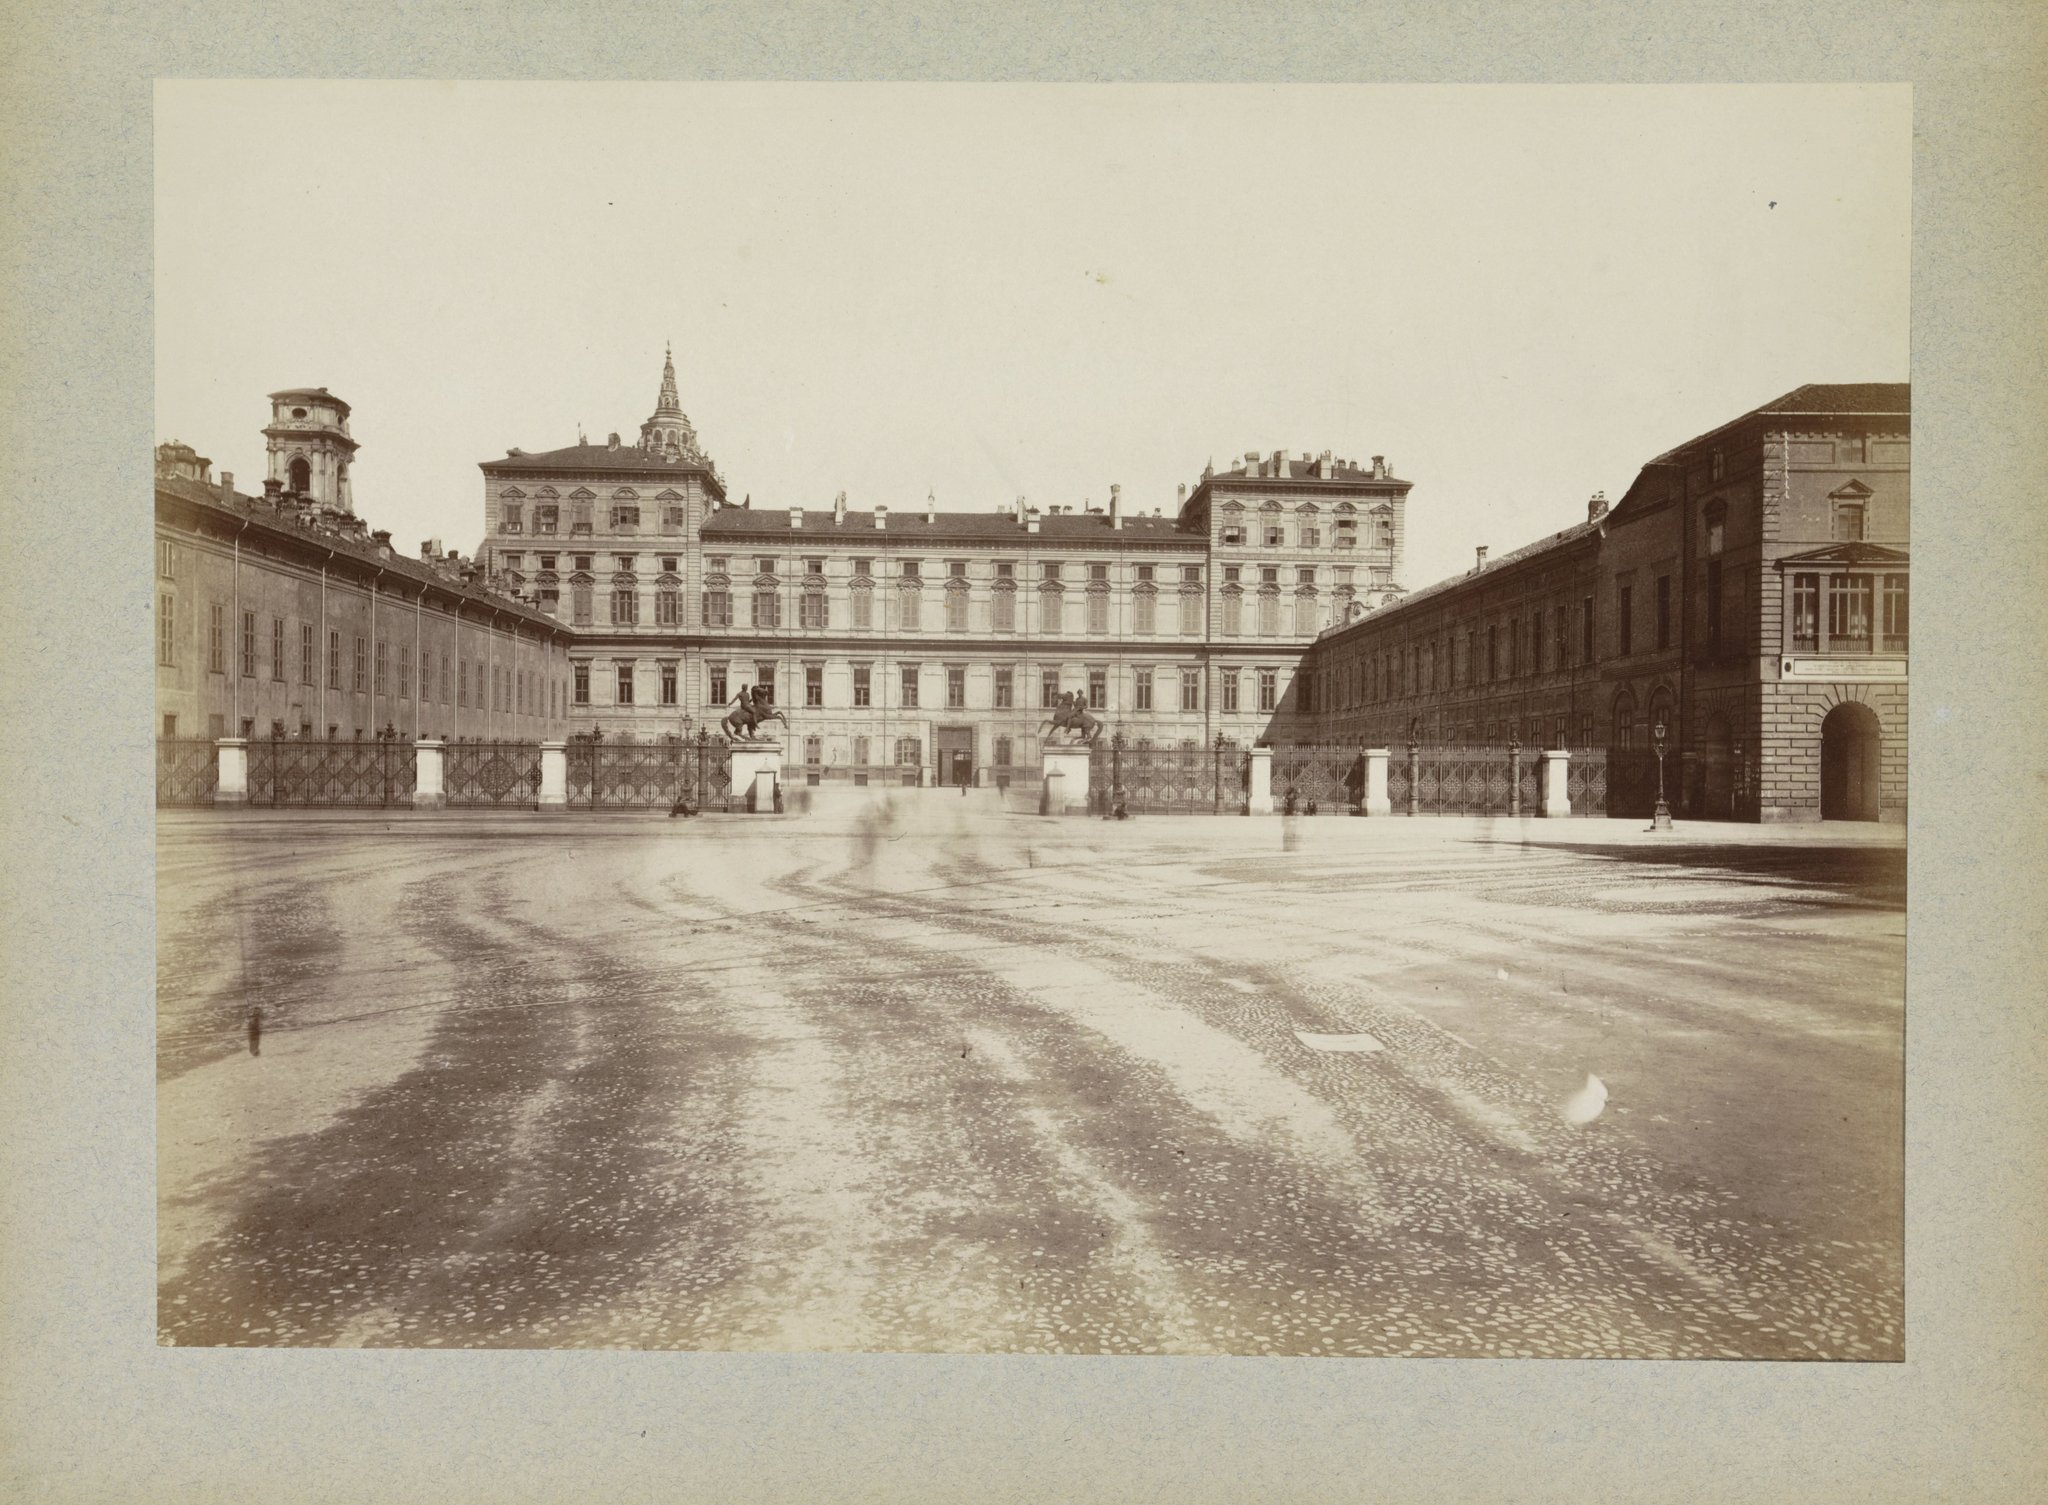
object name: photograph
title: Palazzo Reale in Turijn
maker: Anonymous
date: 1885-1900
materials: paper, photographic support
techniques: albumen print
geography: turin